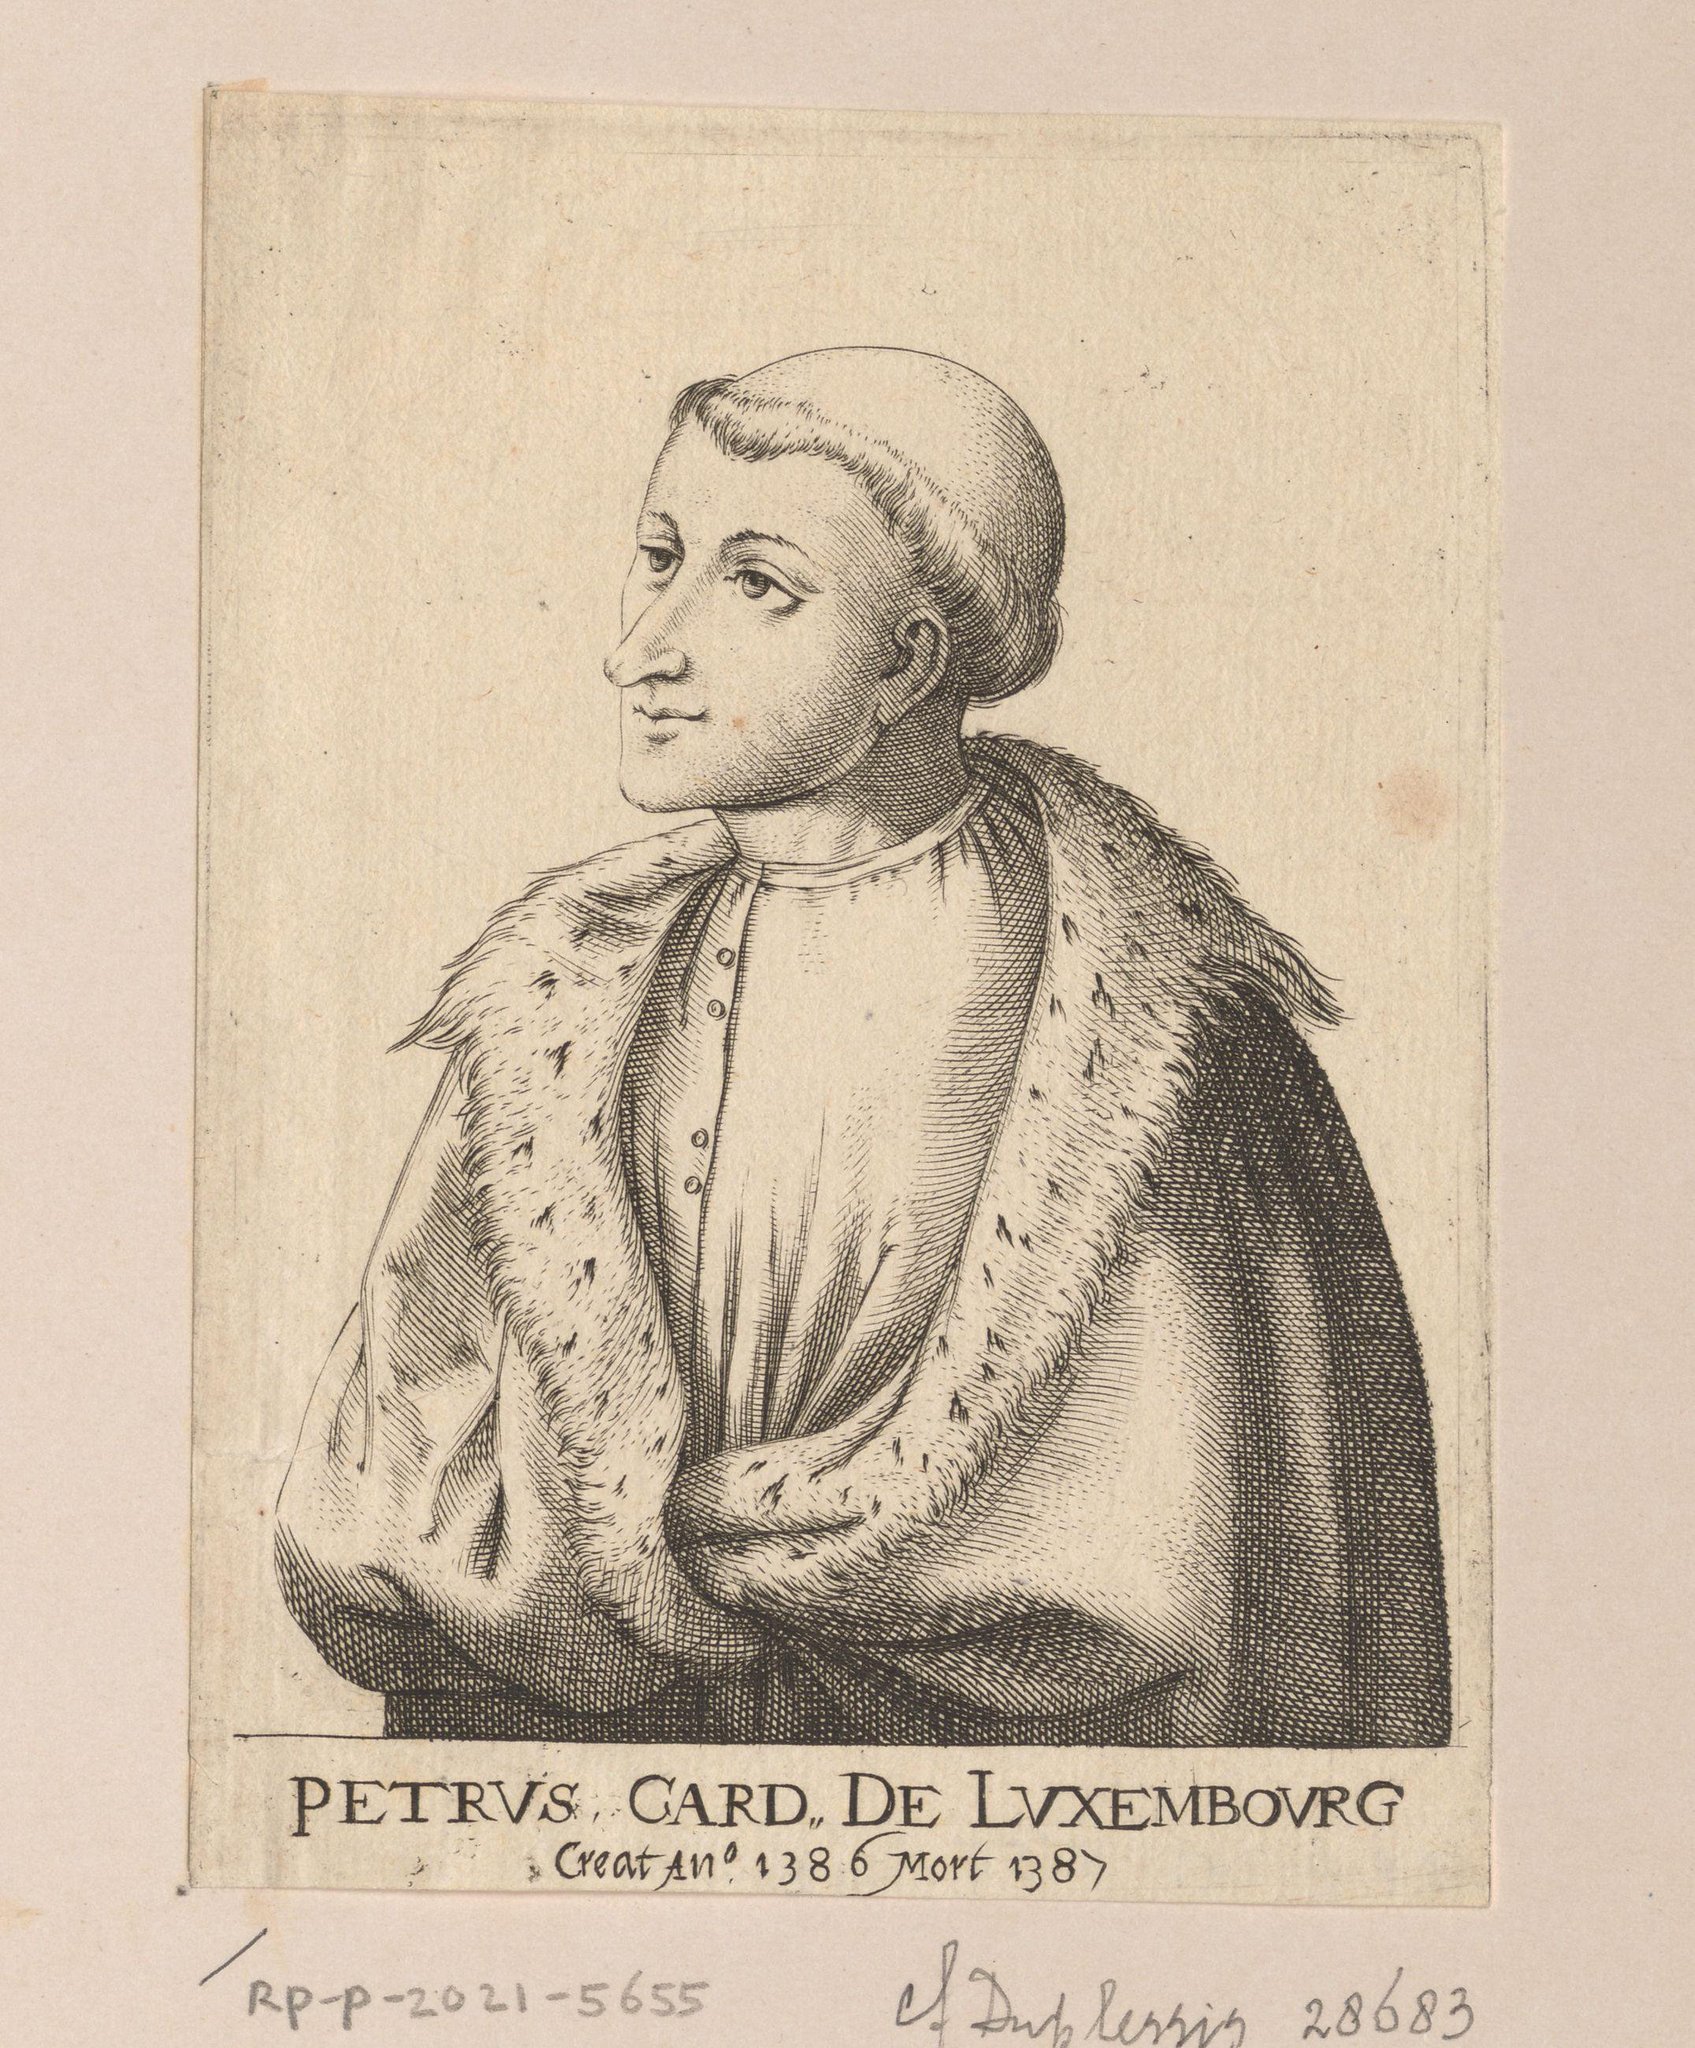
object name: print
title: Portret van Peter van Luxemburg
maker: Anonymous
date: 1670-1720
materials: paper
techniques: engraving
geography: france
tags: cardinal, historical persons